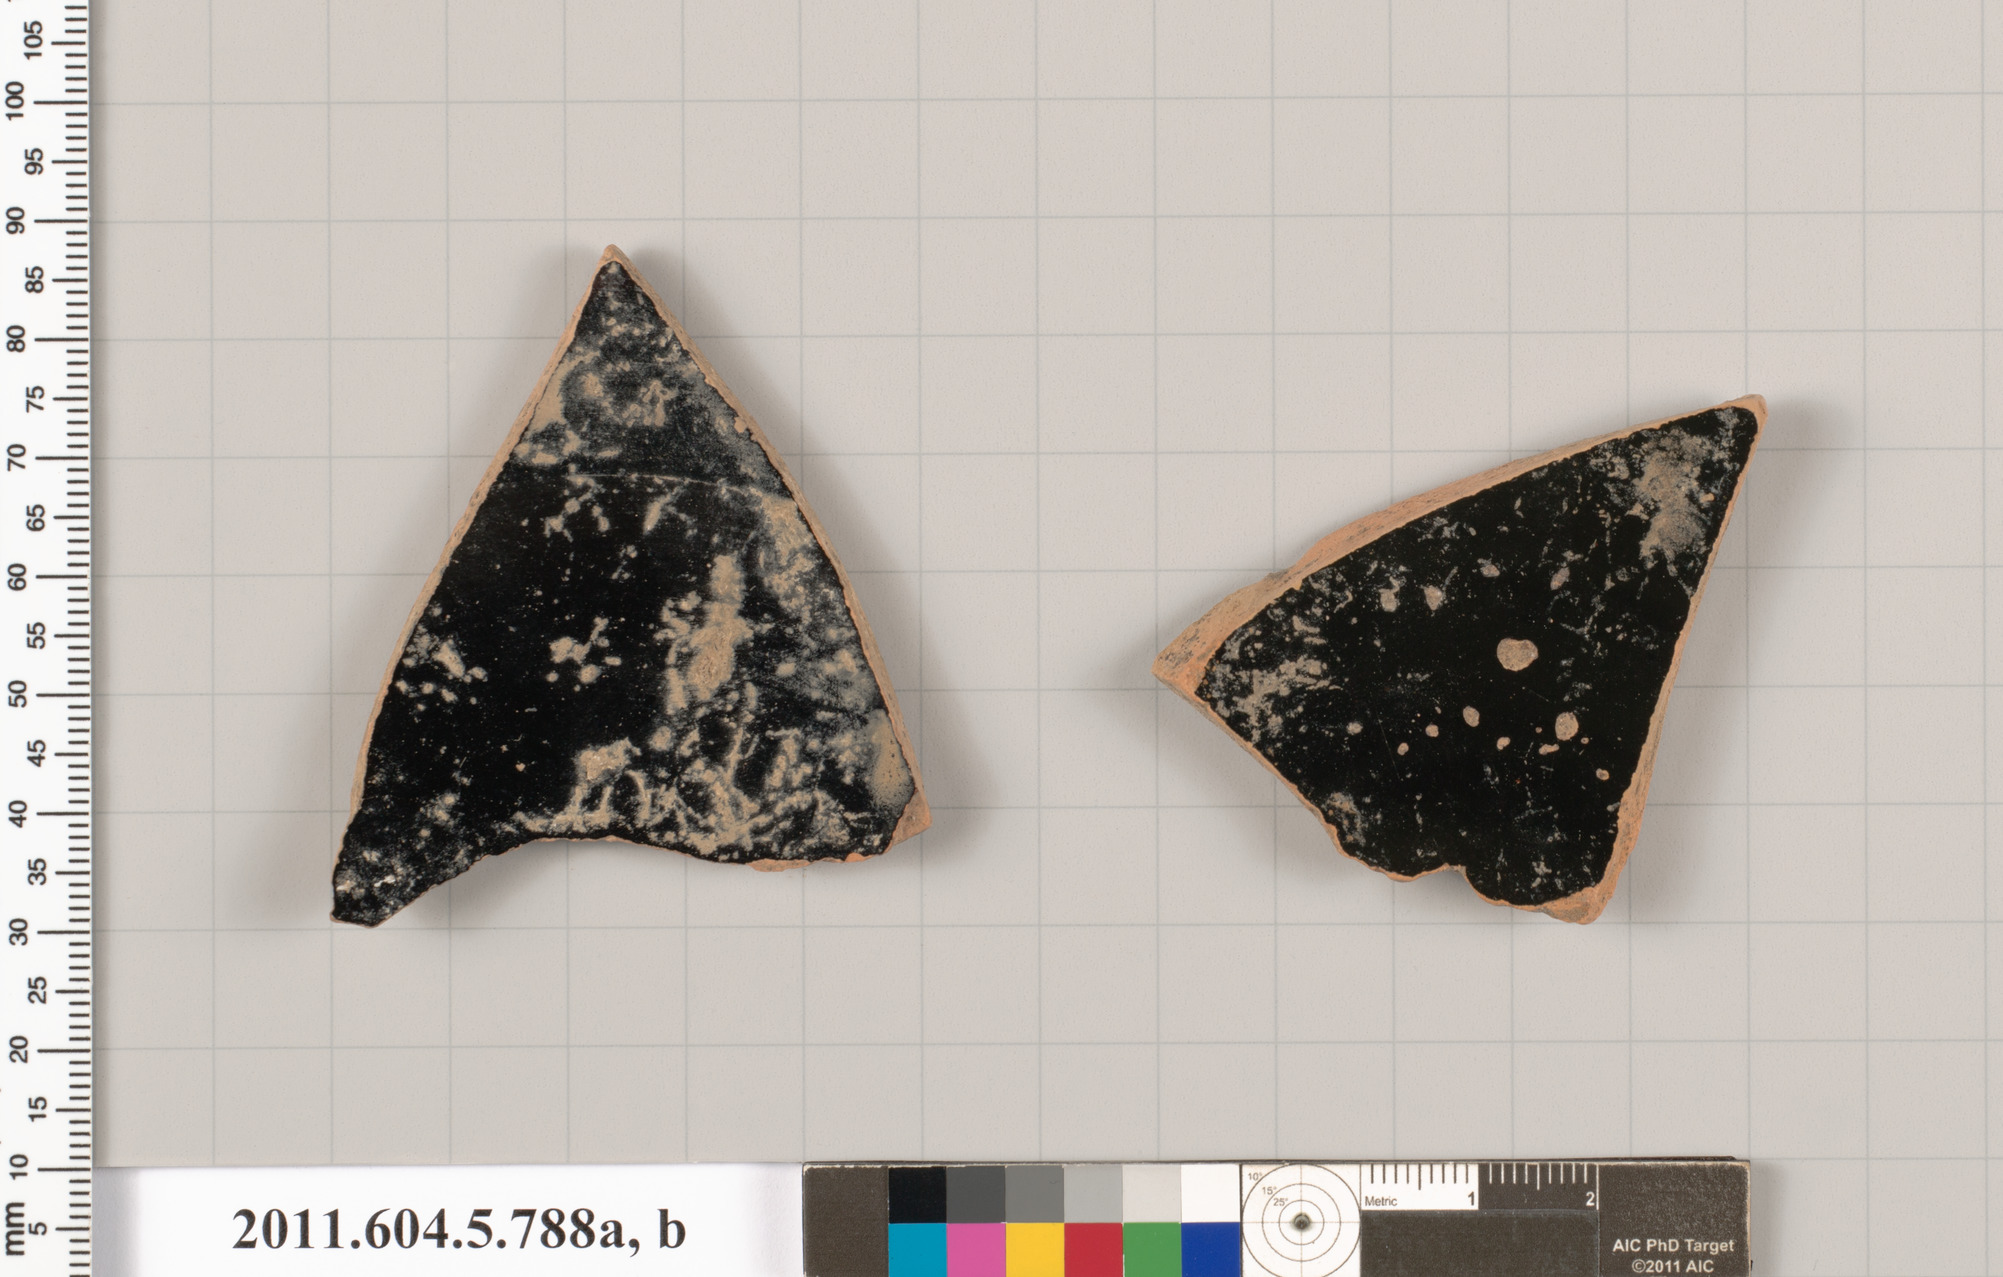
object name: kylix fragment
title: Terracotta fragments of kylikes (drinking cups)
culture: greek, attic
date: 600-401 BCE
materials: terracotta